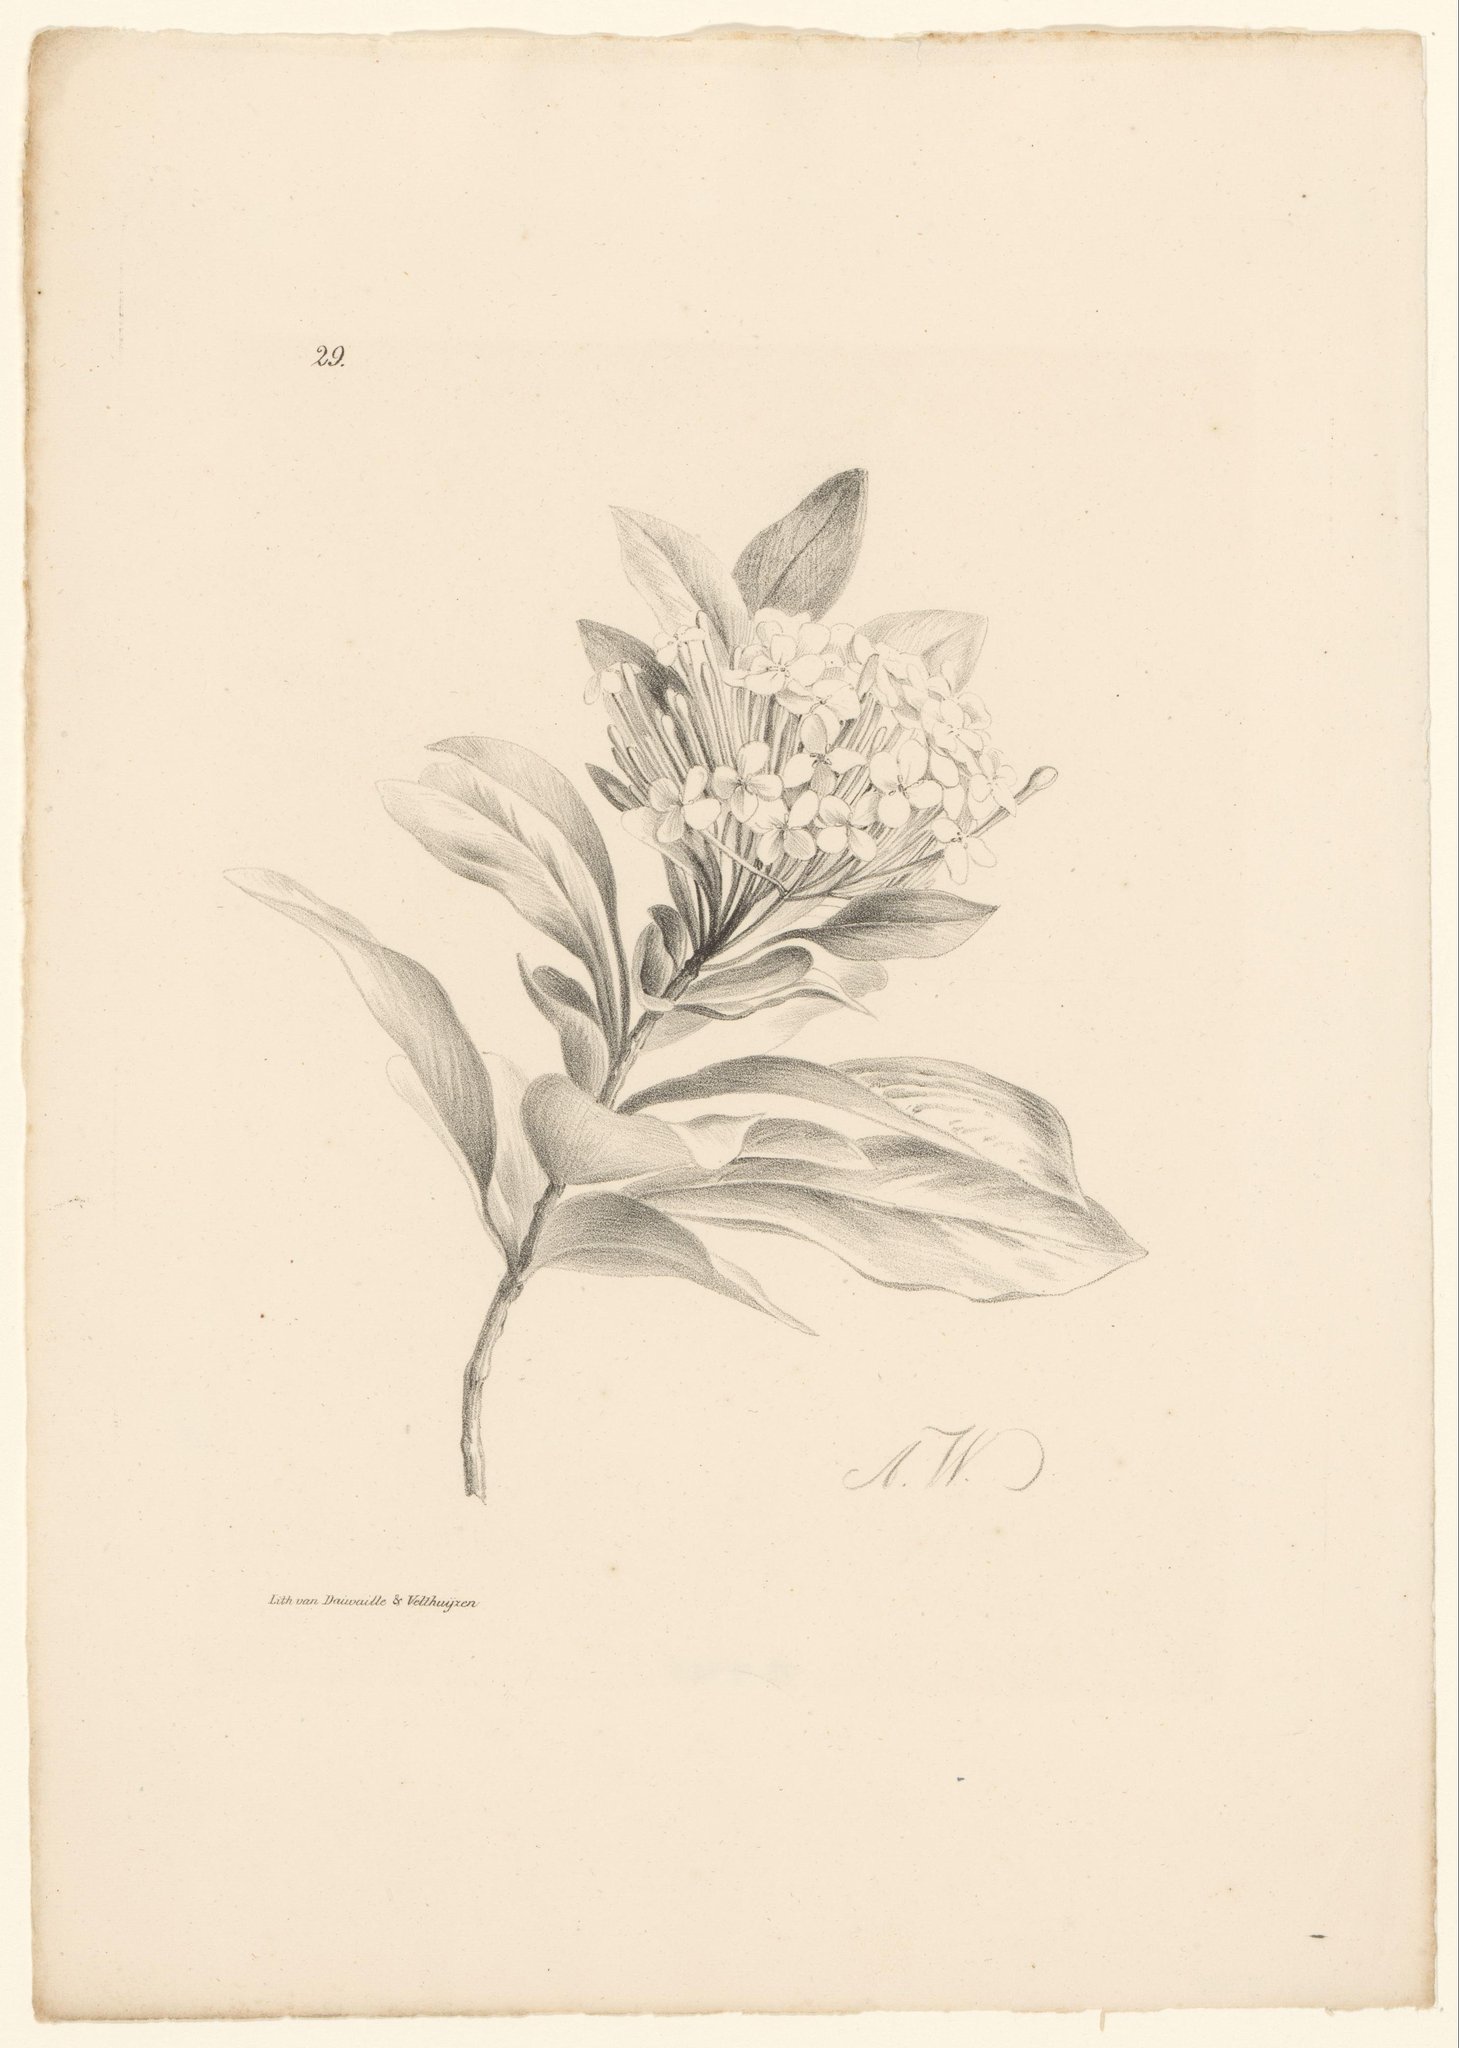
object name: print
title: Bloemen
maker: anton weiss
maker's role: draughtsman, print maker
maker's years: 1801-1851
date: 1831-1832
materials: paper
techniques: lithograph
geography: amsterdam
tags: flowers